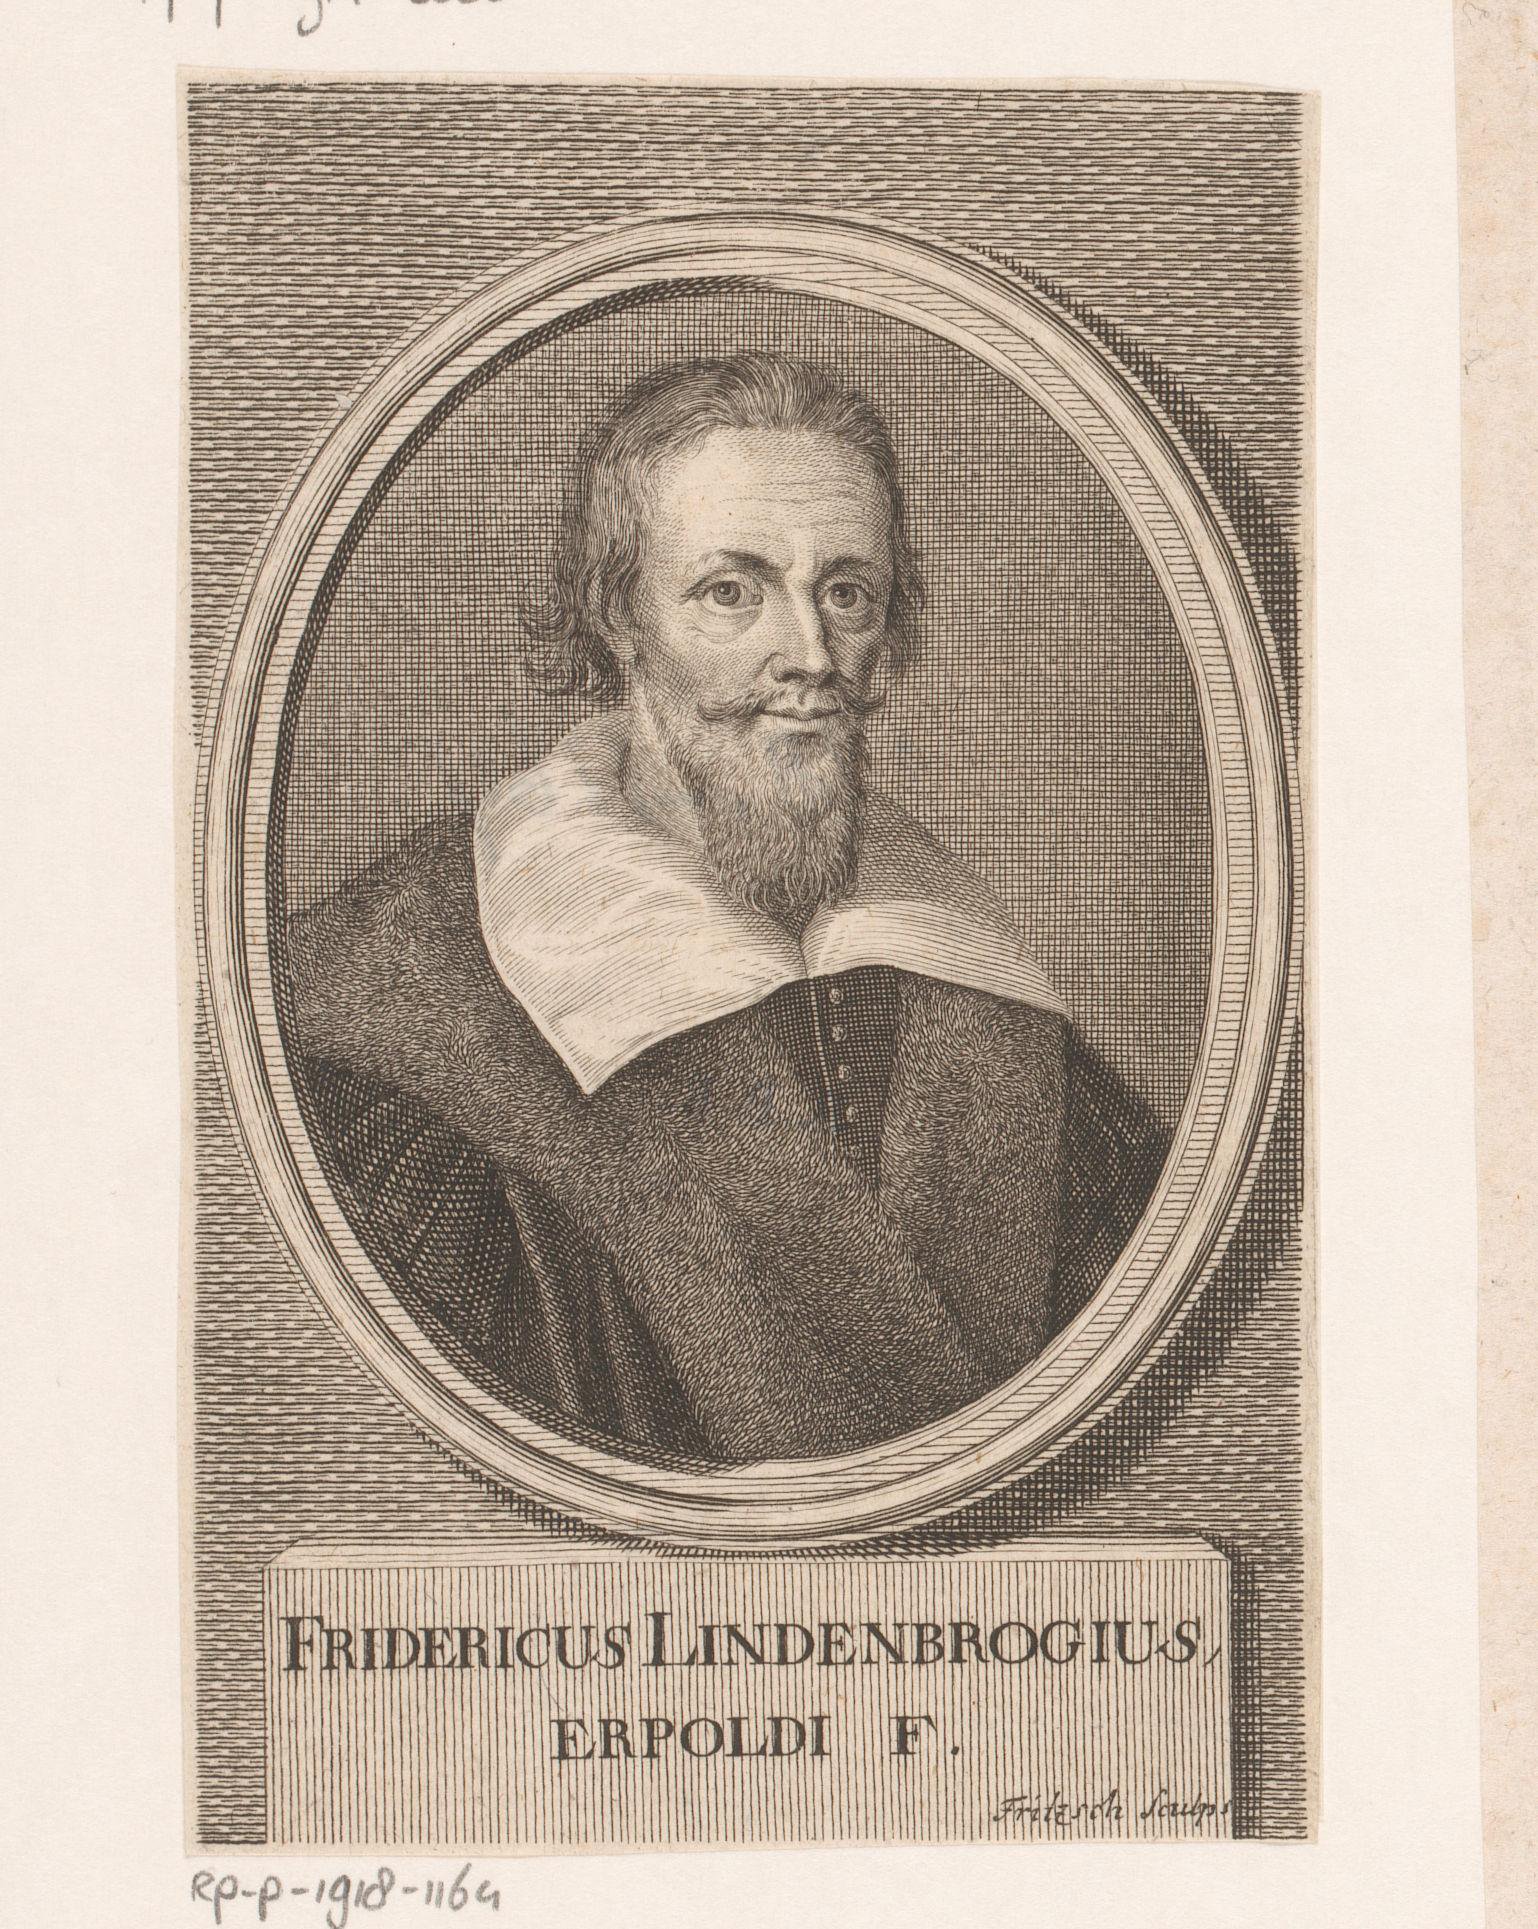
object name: print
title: Portret van Friedrich Lindenbrog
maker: christian fritzsch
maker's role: print maker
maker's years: 1695-1769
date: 1705-1769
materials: paper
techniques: engraving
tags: ornament ~ medallion, historical persons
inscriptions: collector's mark: Lugt 2233